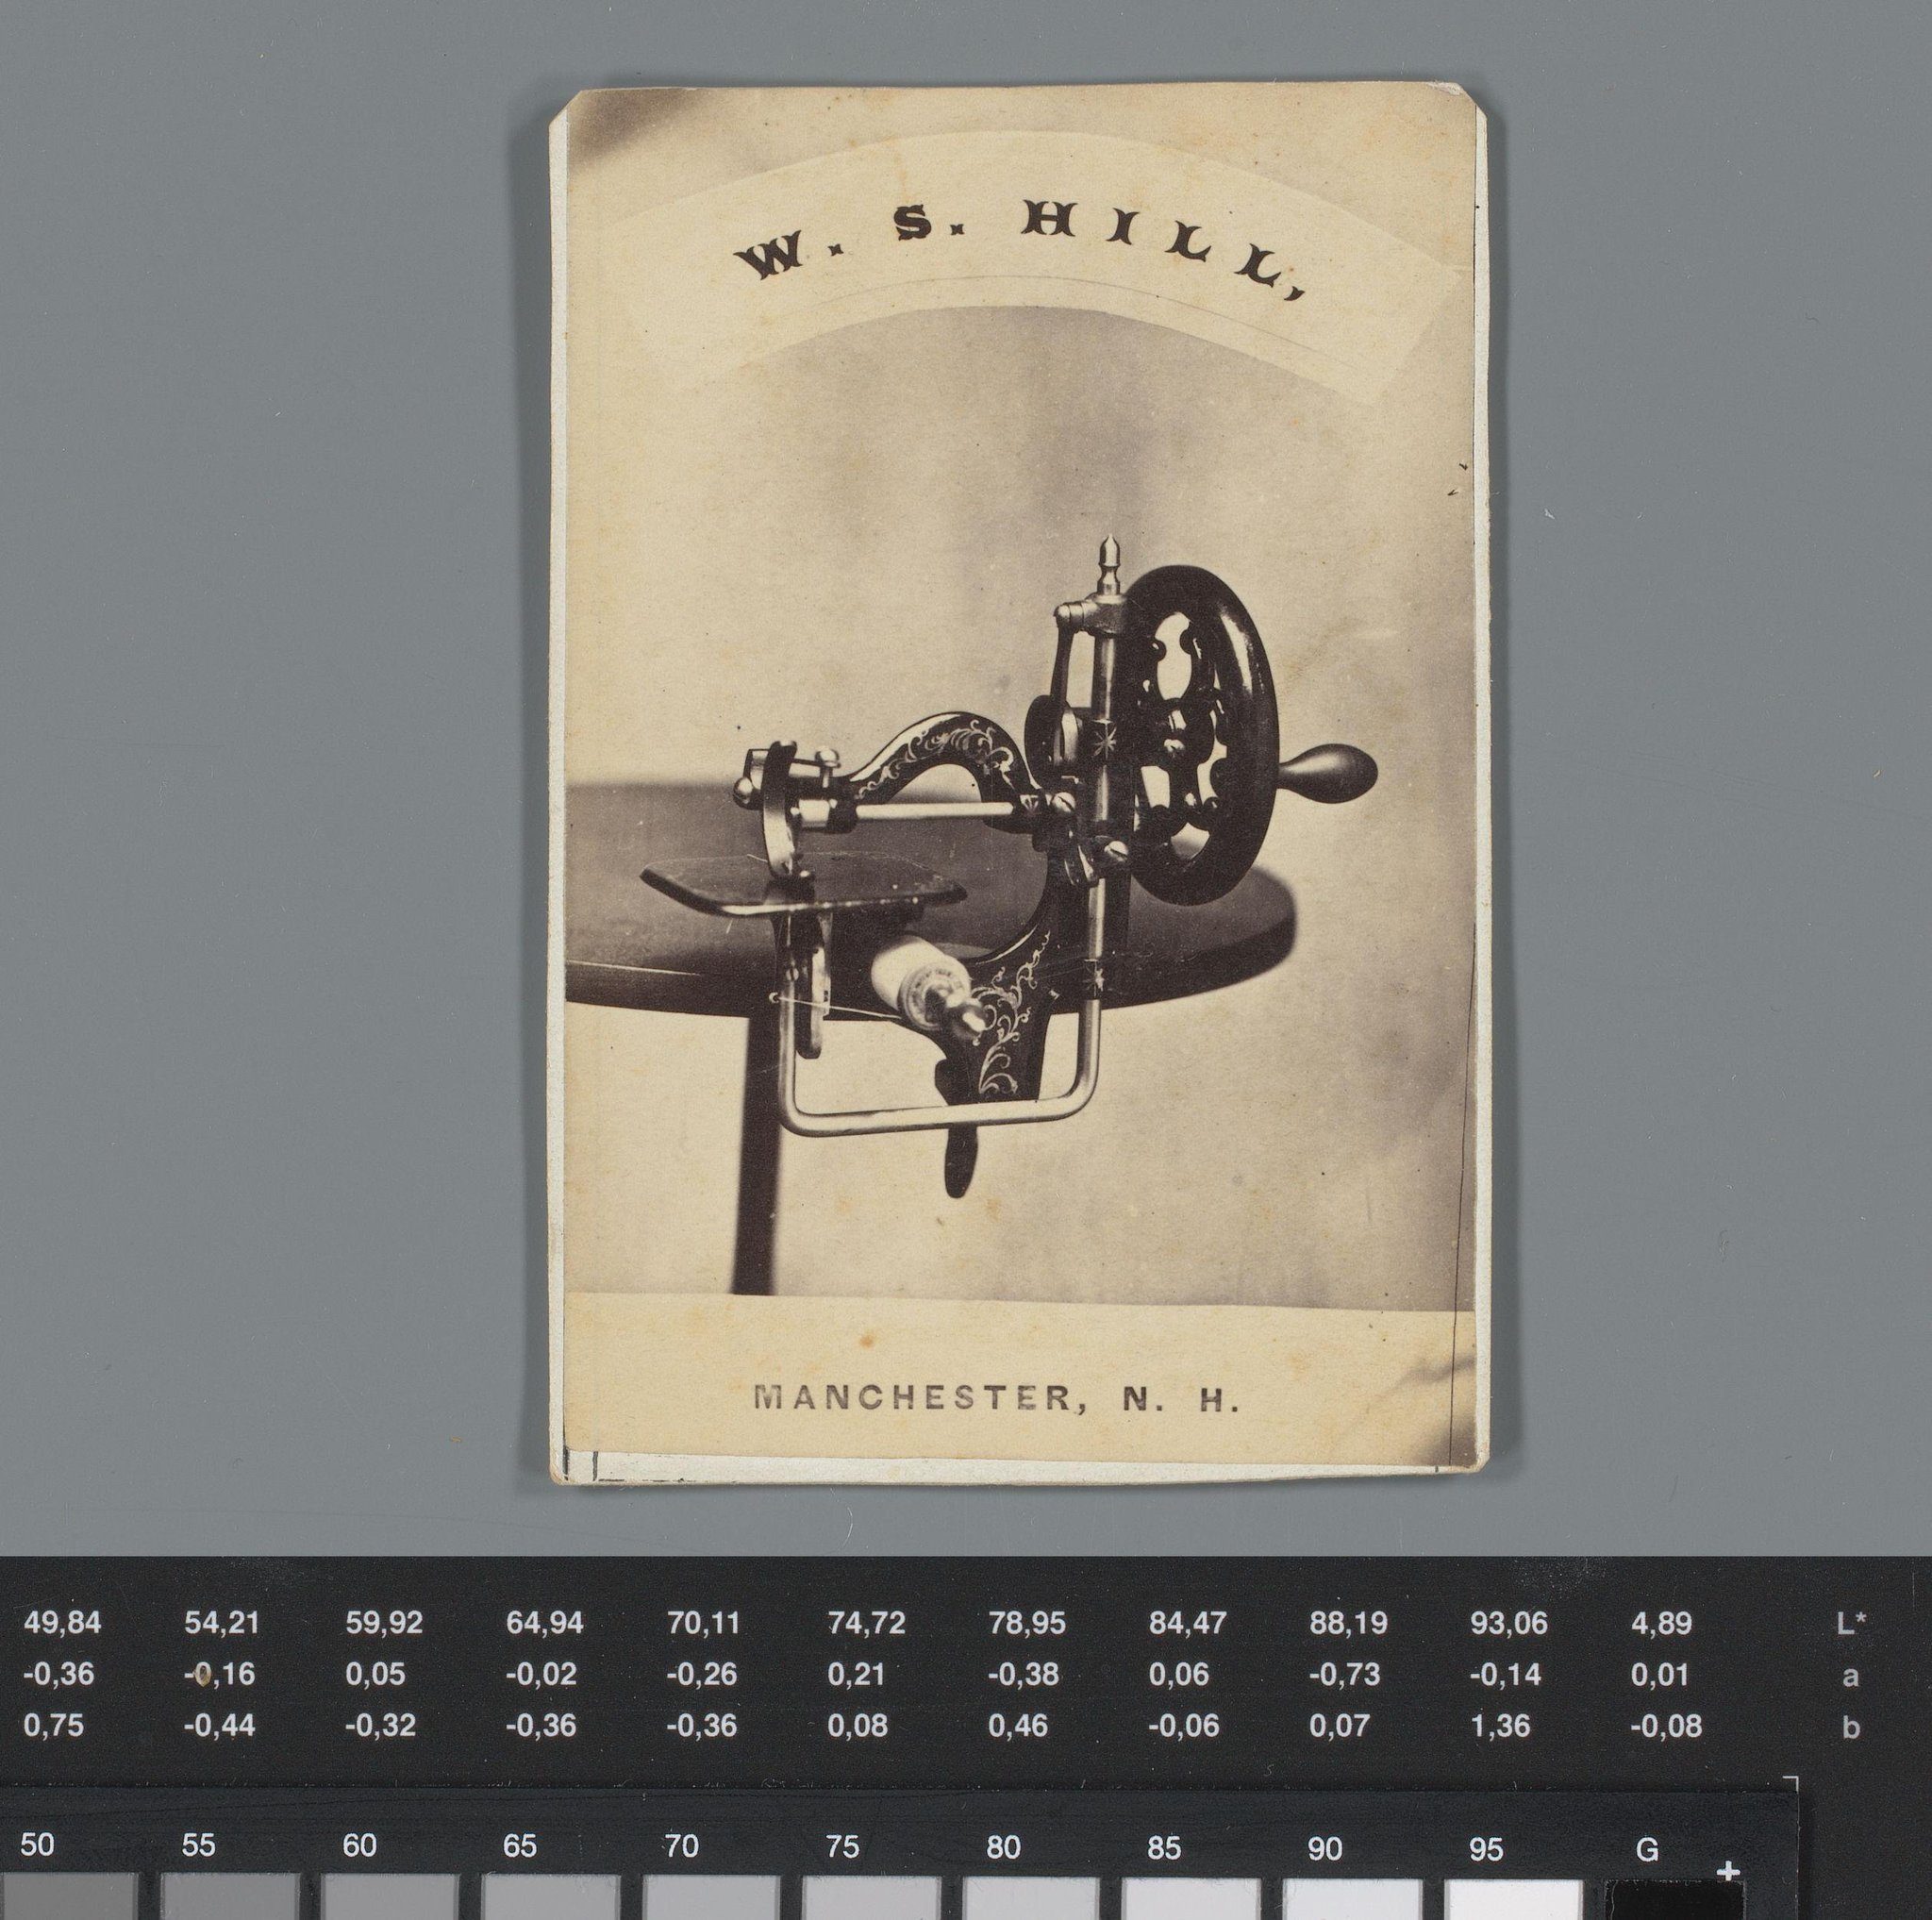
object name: photograph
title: Reclame voor naaimachine van W.S. Hill te Manchester met gezicht op de naaimachine op tafel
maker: Anonymous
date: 1865-1940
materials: cardboard, photographic support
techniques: carbon print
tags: sewing machine, advertising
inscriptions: inscription: ‘OUR NEW TEN DOLLAR / SEWING & EMBROIDERING MACHINE. (...) W. S. HILL, / MANCHESTER. N. H.’